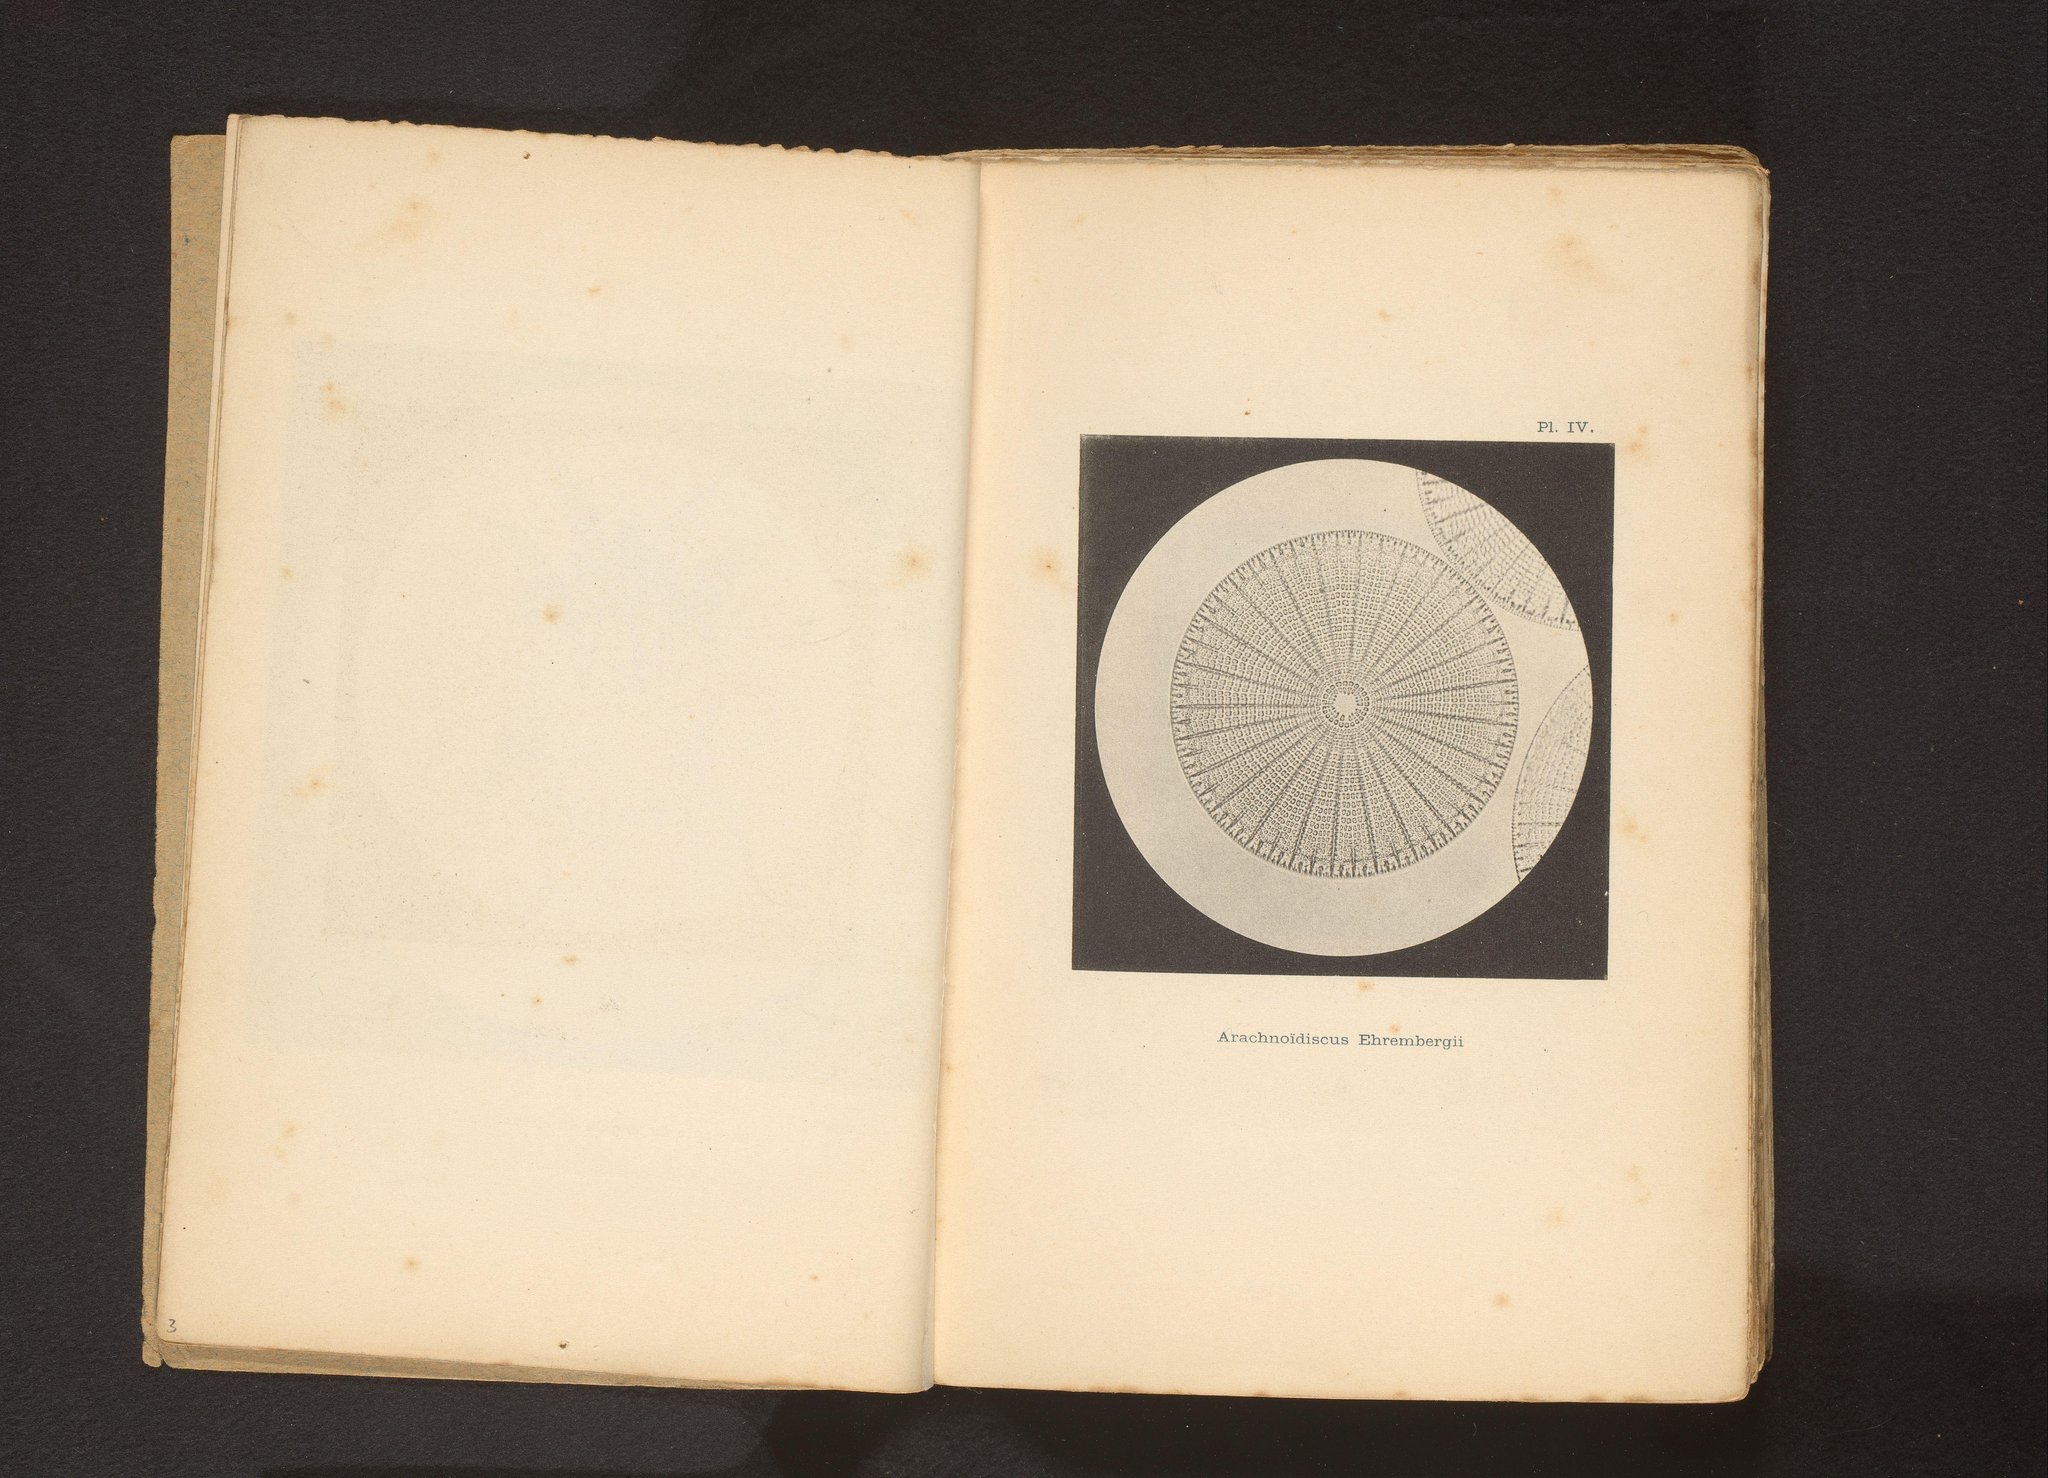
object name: page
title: Microscoopopname van diatomen, ofwel een eencellig wier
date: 1880-1899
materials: paper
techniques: photograph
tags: algae, seaweed, microscope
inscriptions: number: ‘Pl. IV.’